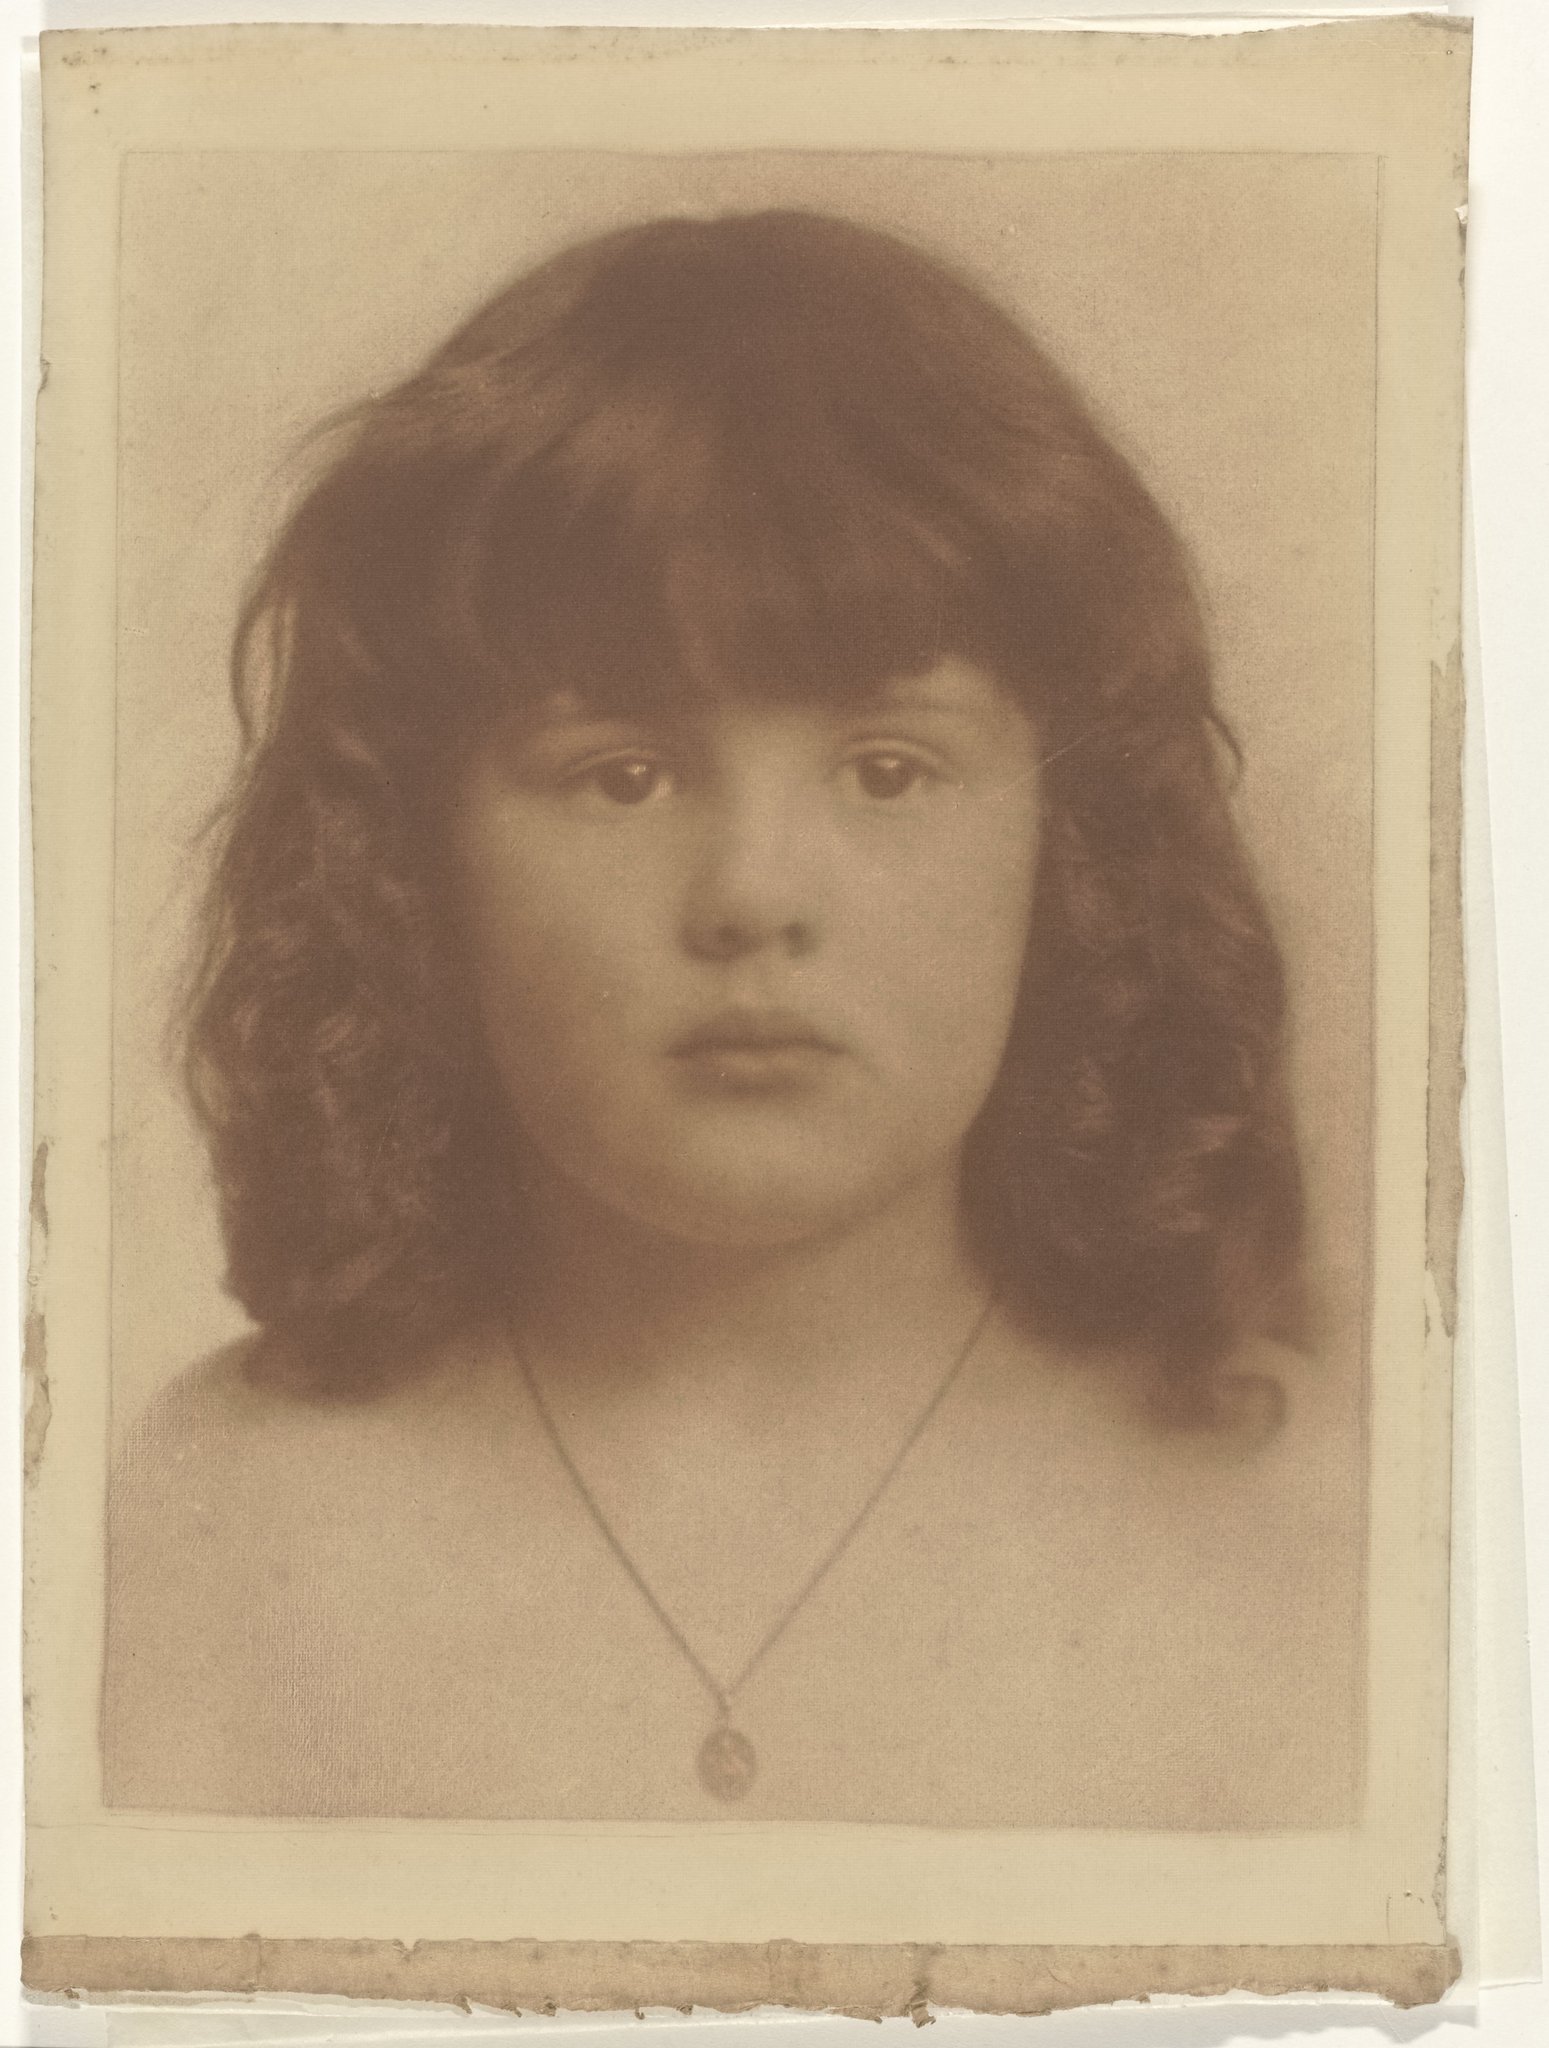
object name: photograph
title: Portret meisje met ketting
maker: jacob merkelbach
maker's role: fotograaf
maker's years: 1877-1942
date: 1910-1930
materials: photographic support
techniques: bromoil process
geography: amsterdam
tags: historical persons not known by name - bb - woman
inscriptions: : ‘meltzer drukker’